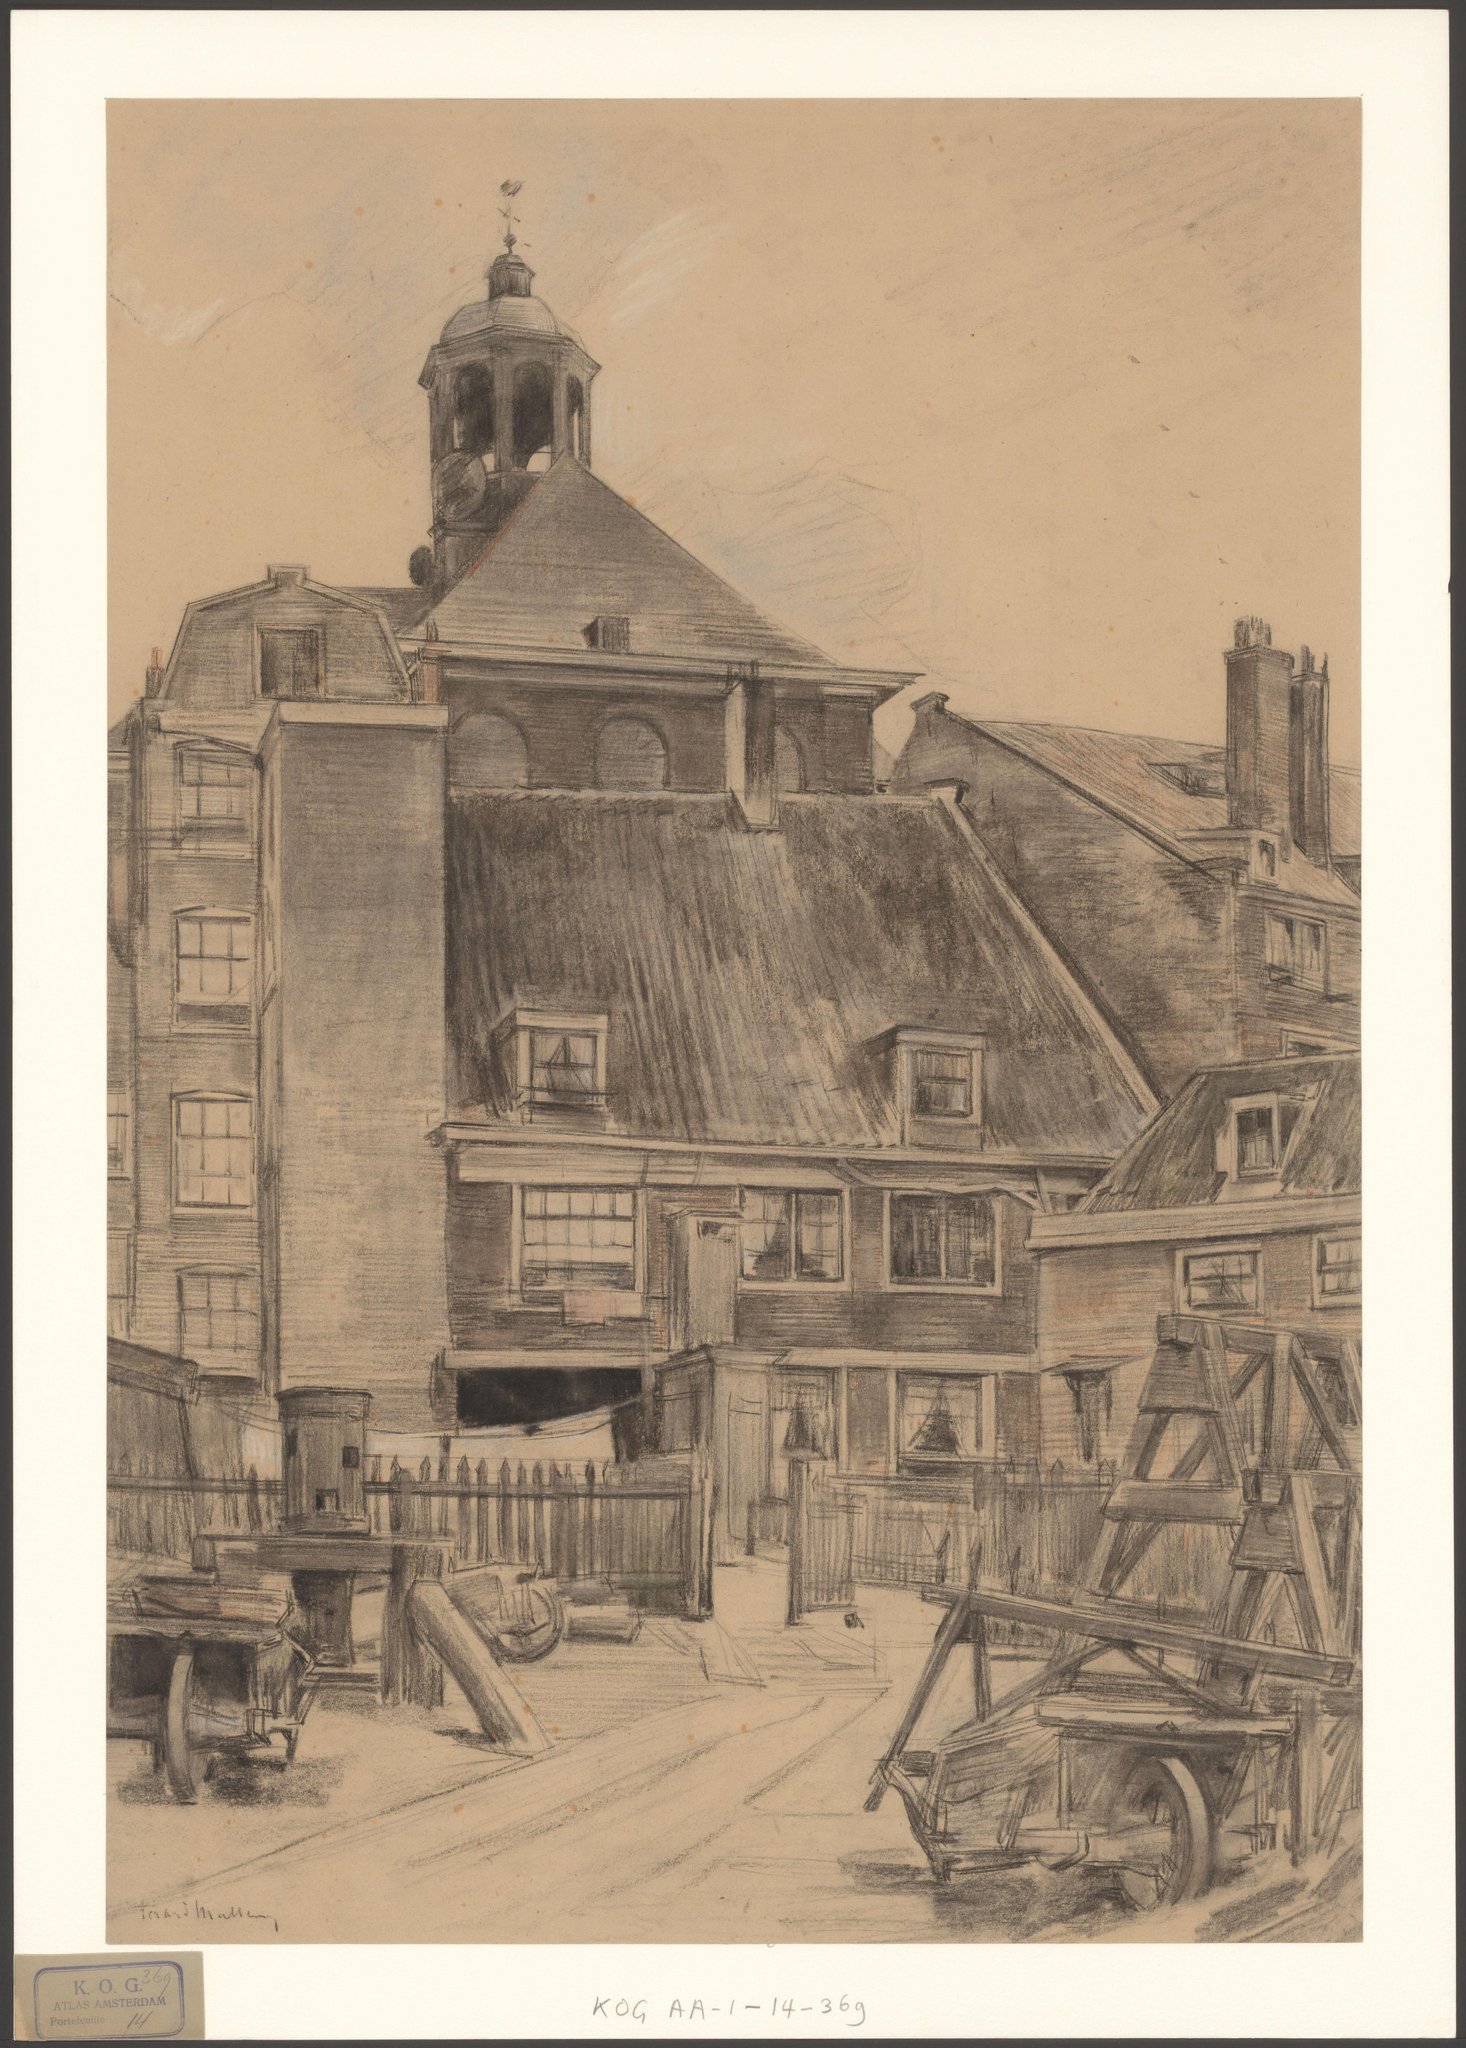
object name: drawing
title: Gezicht op scheepswerf aan de Grote Wittenburgerstraat, gezien naar de Oosterkerk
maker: Anonymous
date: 1850-1899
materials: chalk, paper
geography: amsterdam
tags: city-view in general; 'veduta', church (exterior), pier, quay, wharf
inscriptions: inscription: ‘Port. 14 - 369’, collector's mark: ‘14’ Lugt 1641b, signature: ‘F[...]ra[...] Mall[...]’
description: Onderwerpsrubriek binnen de Atlas Amsterdam: Waal (Kromme en Oude), Walenpleintje, Warmoesgracht, Warmoesstraat, Waterlooplein, Westerdoksdijk, Westermarkt, Weteringschans, Willemspark, Willemsstraat, Wittenburg, Wittenkade (de), Wittenstraat (de).